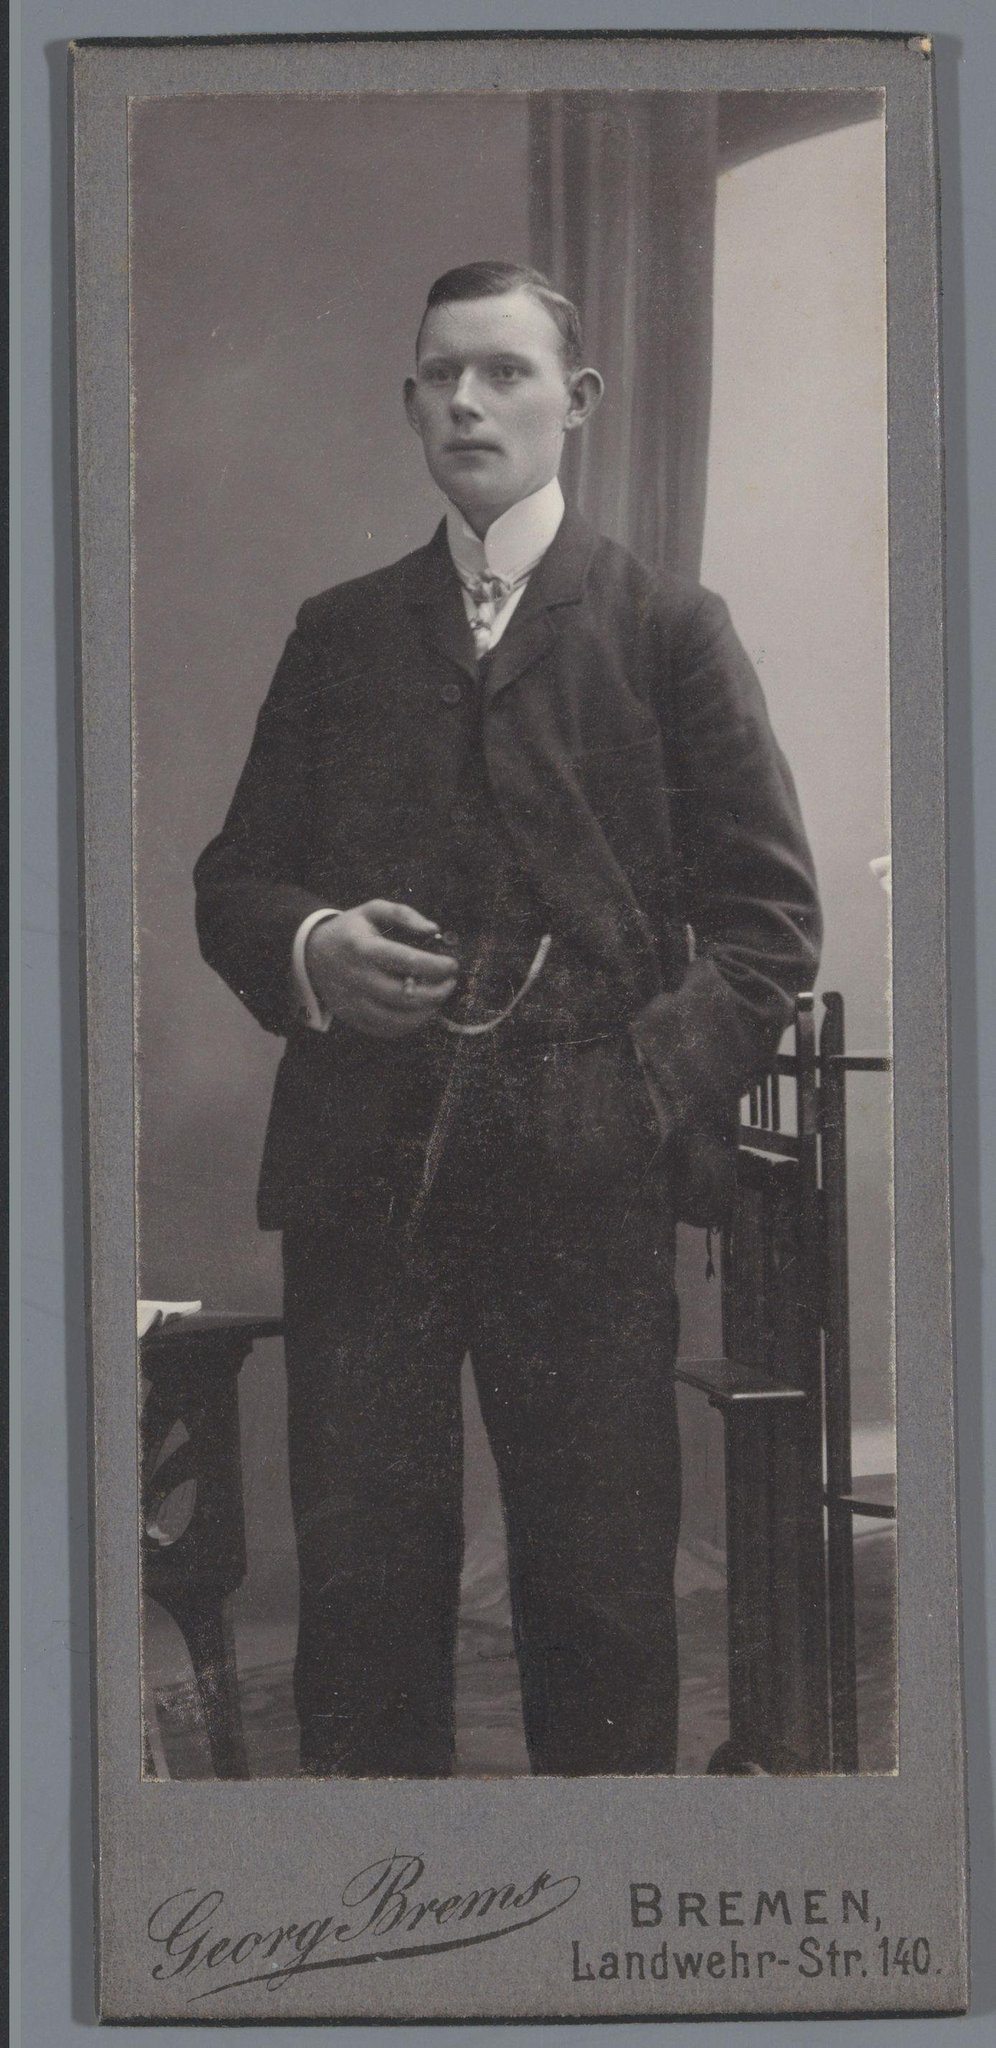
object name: photograph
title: Portret van een onbekende man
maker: georg brems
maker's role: fotograaf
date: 1900-1914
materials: paper, cardboard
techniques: gelatin silver print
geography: bremen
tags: adult man, anonymous historical person portrayed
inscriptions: address: ‘Bremen,/ Landwehr-Str. 140’